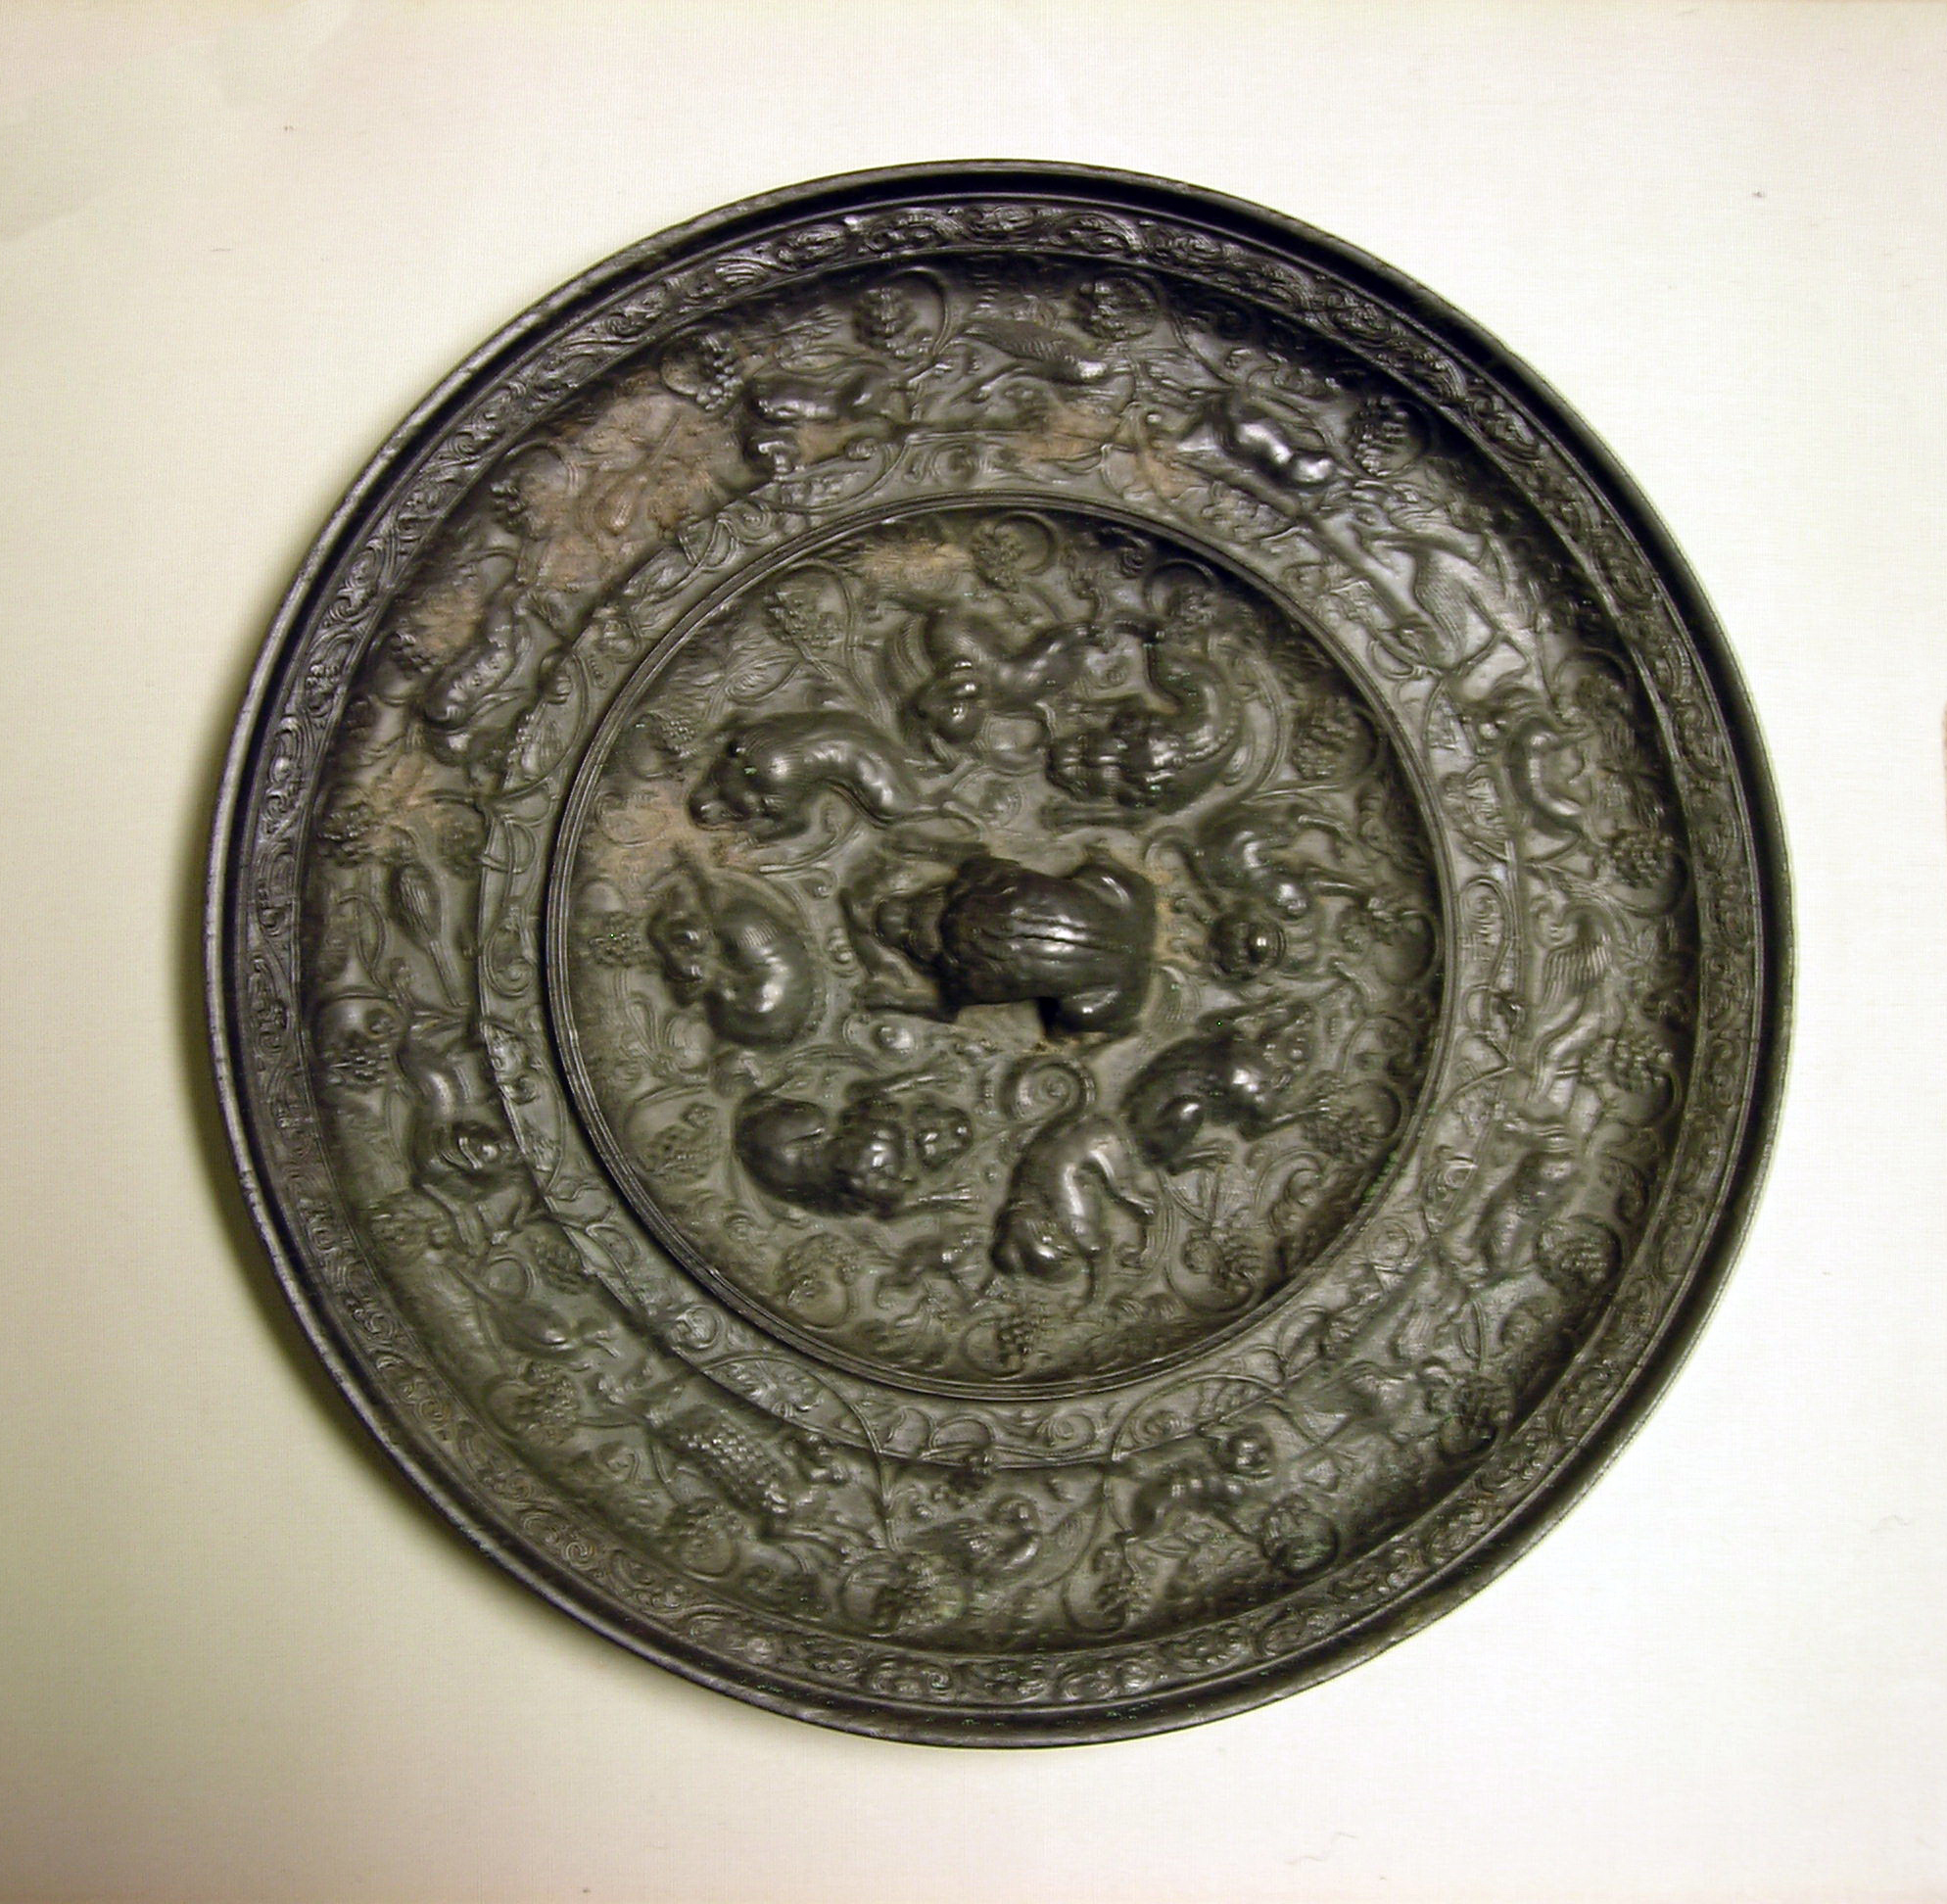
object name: mirror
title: Mirror with fantastic animals amid grape vines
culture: chinese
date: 601-700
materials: bronze